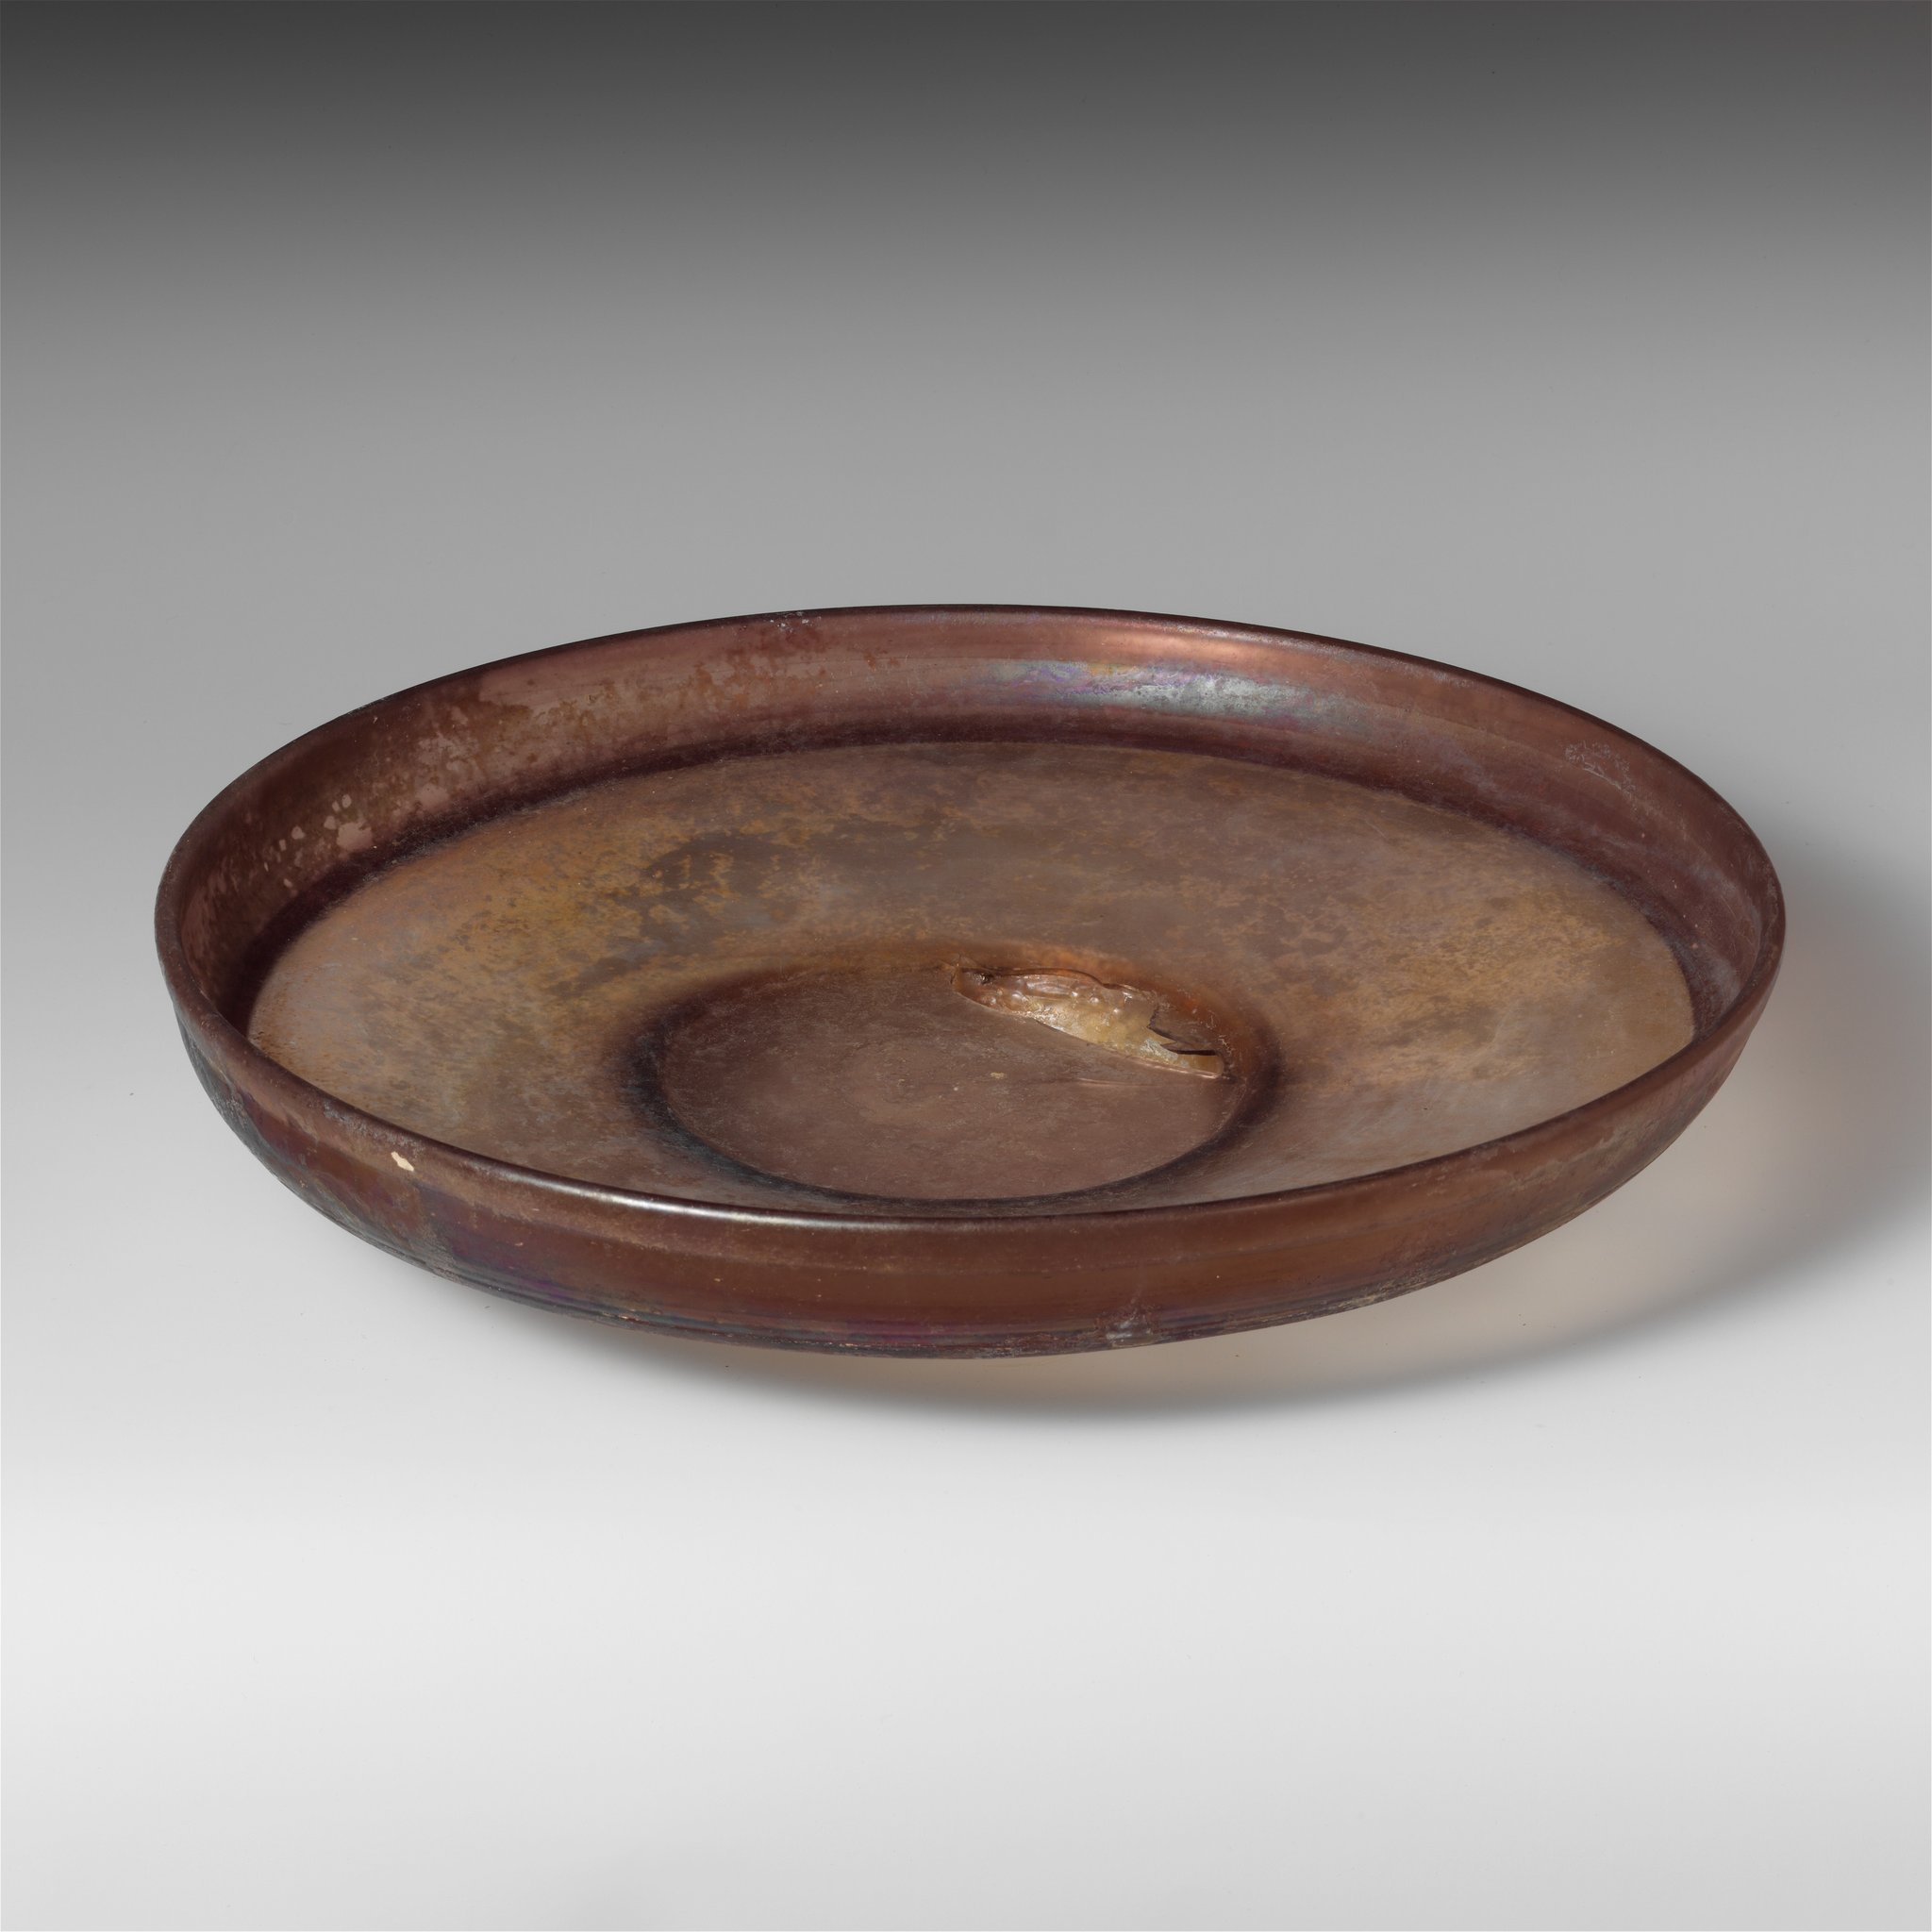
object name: dish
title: Glass dish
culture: roman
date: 301-500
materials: glass